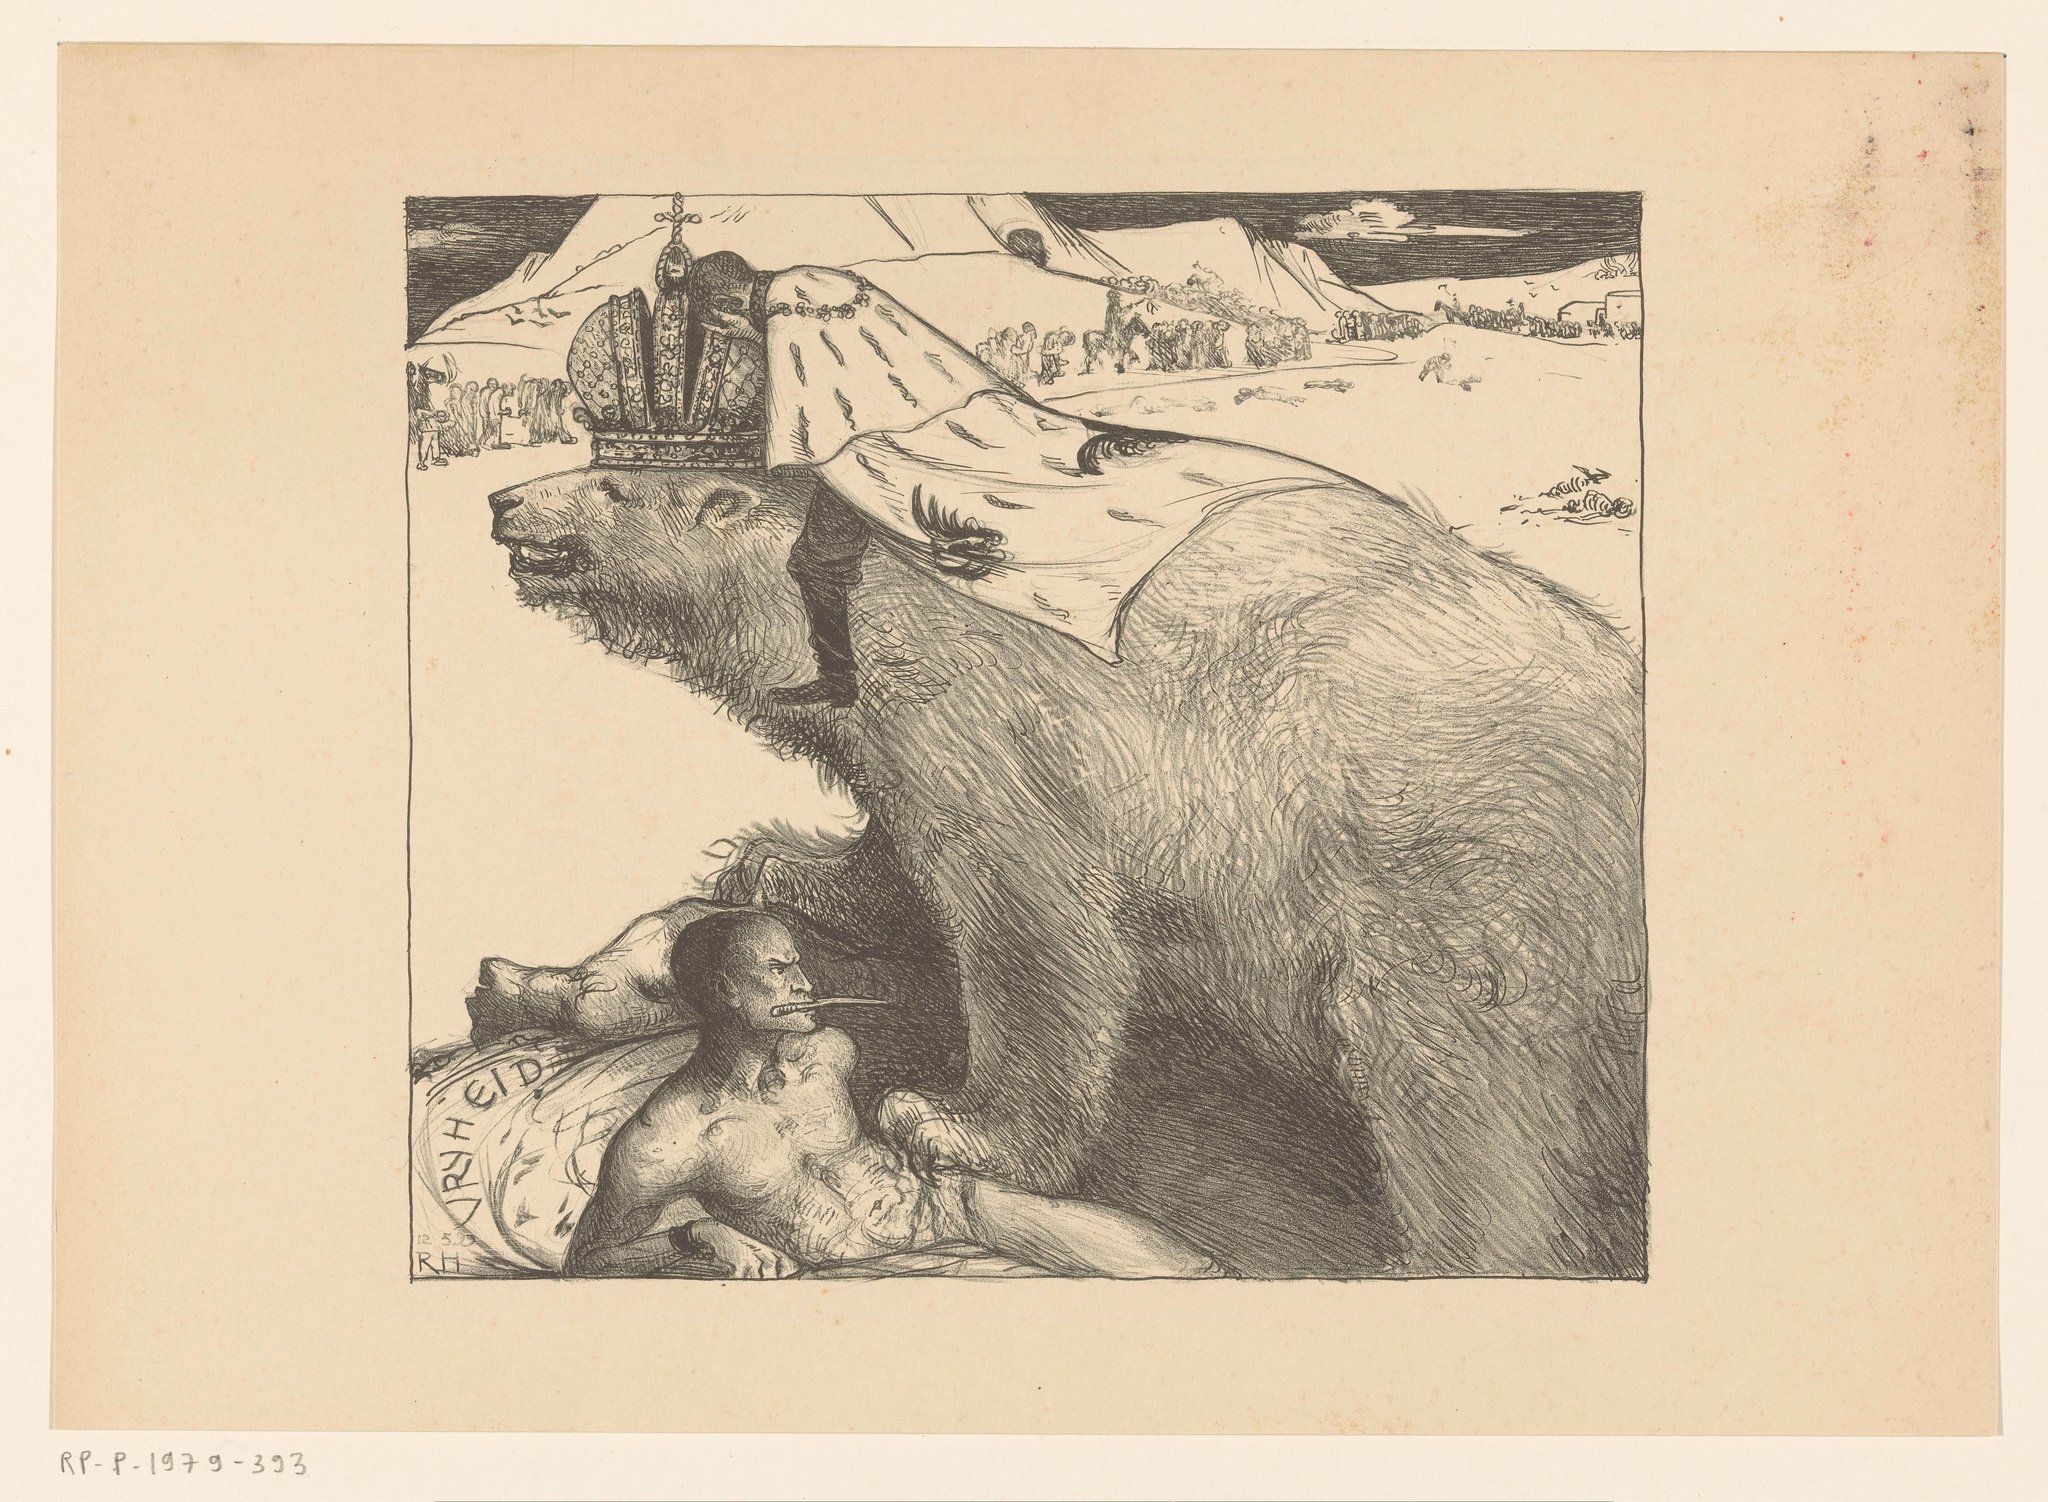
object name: cartoon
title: Tsaar Nicolaas II van Rusland op de Russische beer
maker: richard nicolaüs roland holst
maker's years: 1868-1938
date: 1899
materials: paper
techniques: lithograph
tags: crown (symbol of sovereignty), deportation, beasts of prey, predatory animals: bear, freedom, liberty; 'libertà' (ripa), symbols of particular nations, states, districts, etc., russia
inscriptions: collector's mark: Lugt 2228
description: Prent gebruikt voor: 'De Plaat', het bijvoegsel van 'De Sociaaldemokraat, orgaan der Sociaaldemokratische Arbeiderspartij in Nederland'. Bij de prent verscheen een tekst van Henriëtte Roland Holst-van der Schalk met de titel 'De Russische beer brult vrede' waarin wordt ingegaan op de inhoud van de prent: 'Hoe verhoudt gij u, Russische beer, tegen Recht, Vrijheid en Broederschap, die wegbereiders van Vrede? Hoe staat het daarmee bij u, klein nietigheidje, angstig berijder van het monster Autokratie met zijn krachtigen klauw en listige oogjes, bij u, Tzar van Rusland?'